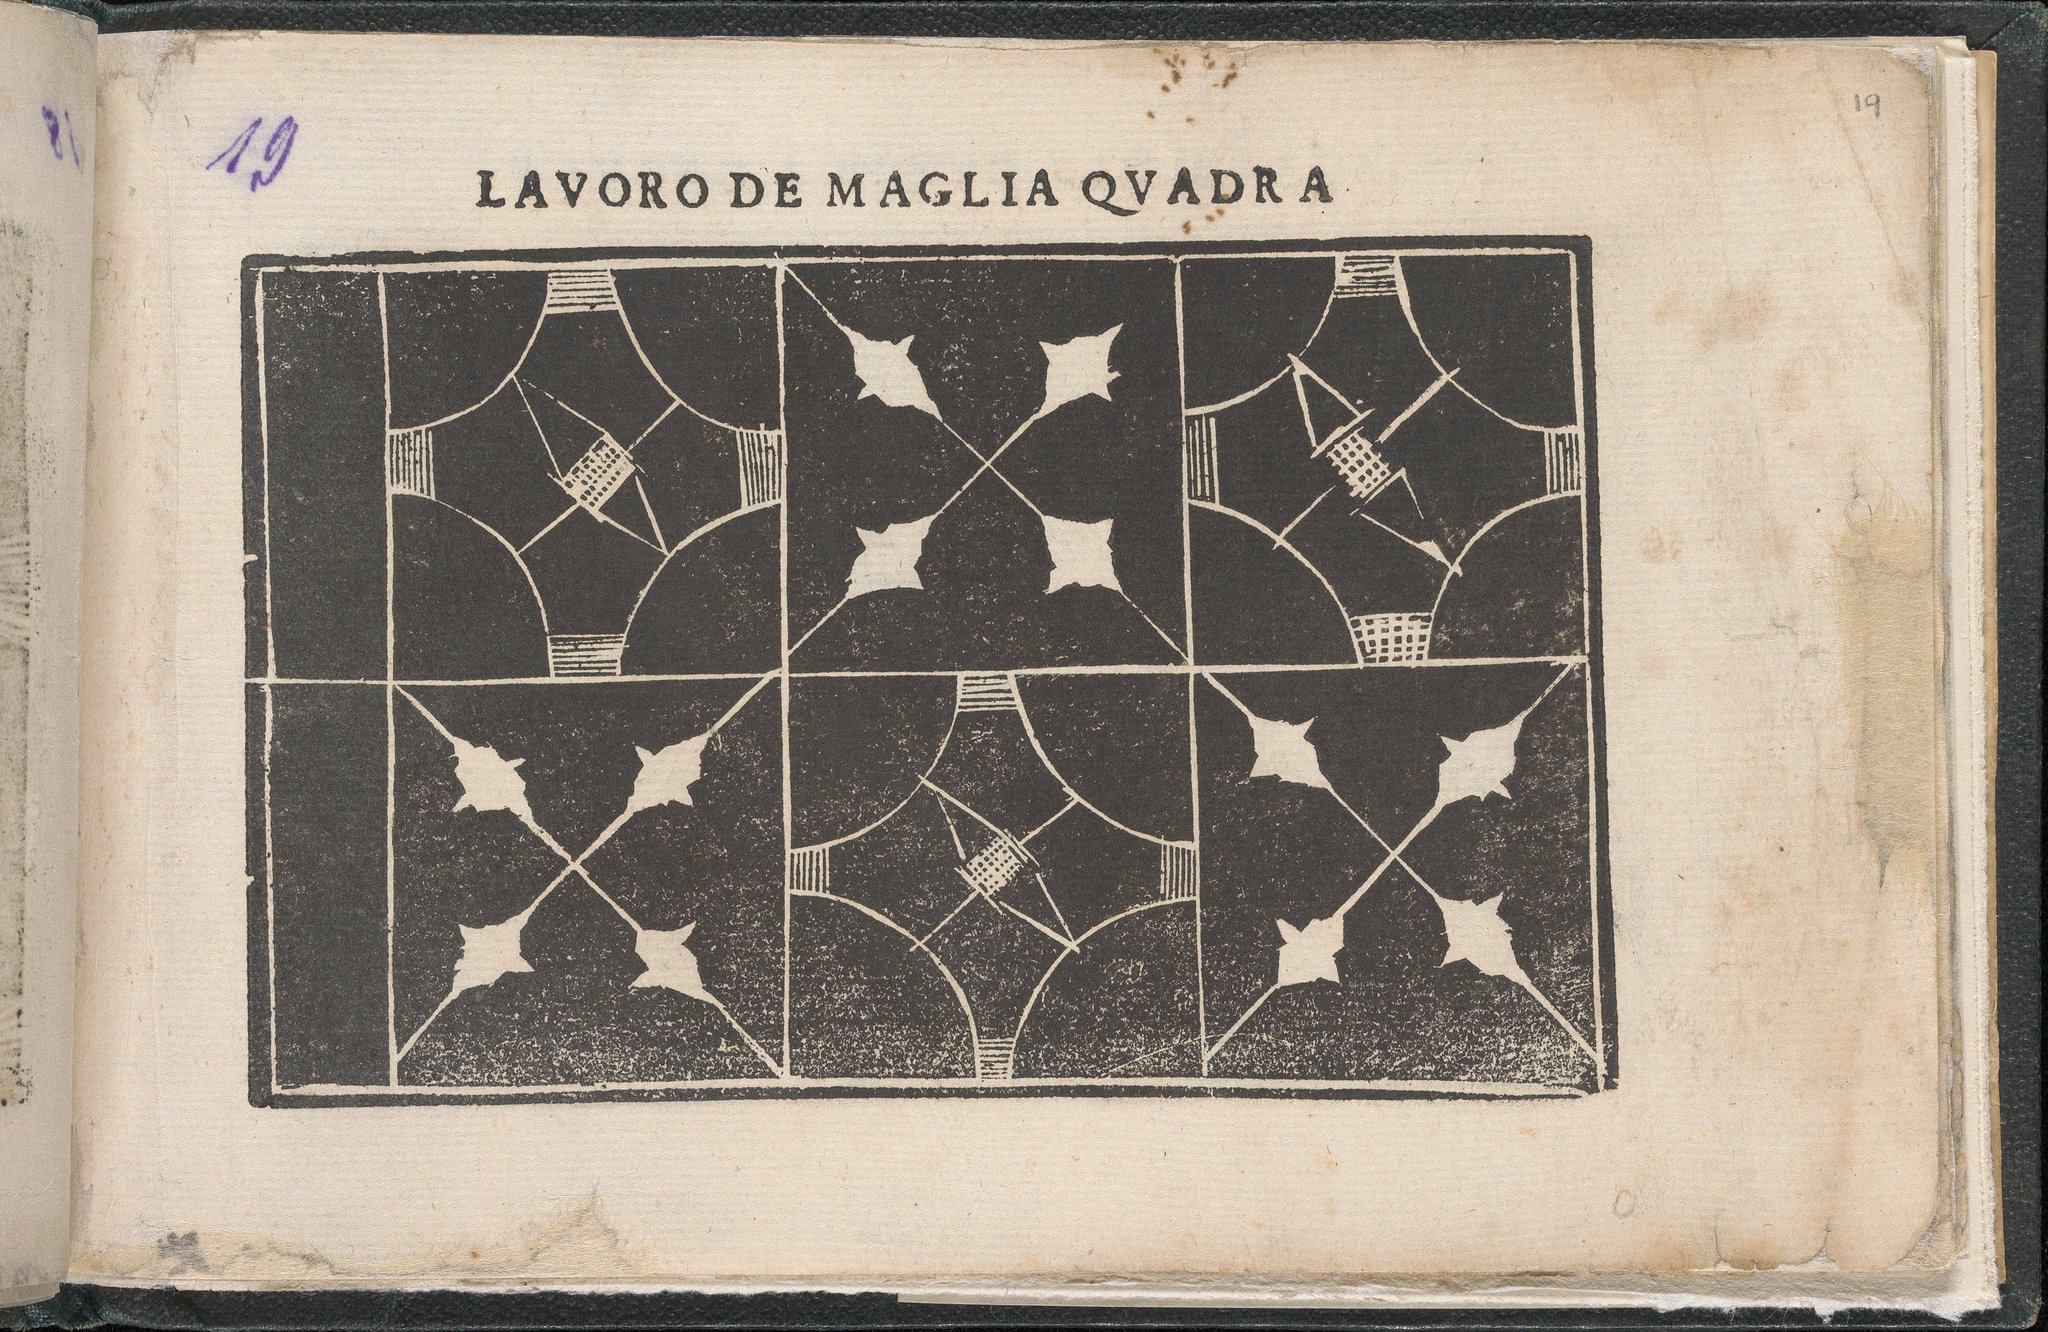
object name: book print ornament architecture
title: Gemma pretiosa della virtuose donne, page 19 (recto)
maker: isabella catanea parasole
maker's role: designer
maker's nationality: italian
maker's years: 1565-1625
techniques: woodcut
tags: ornament